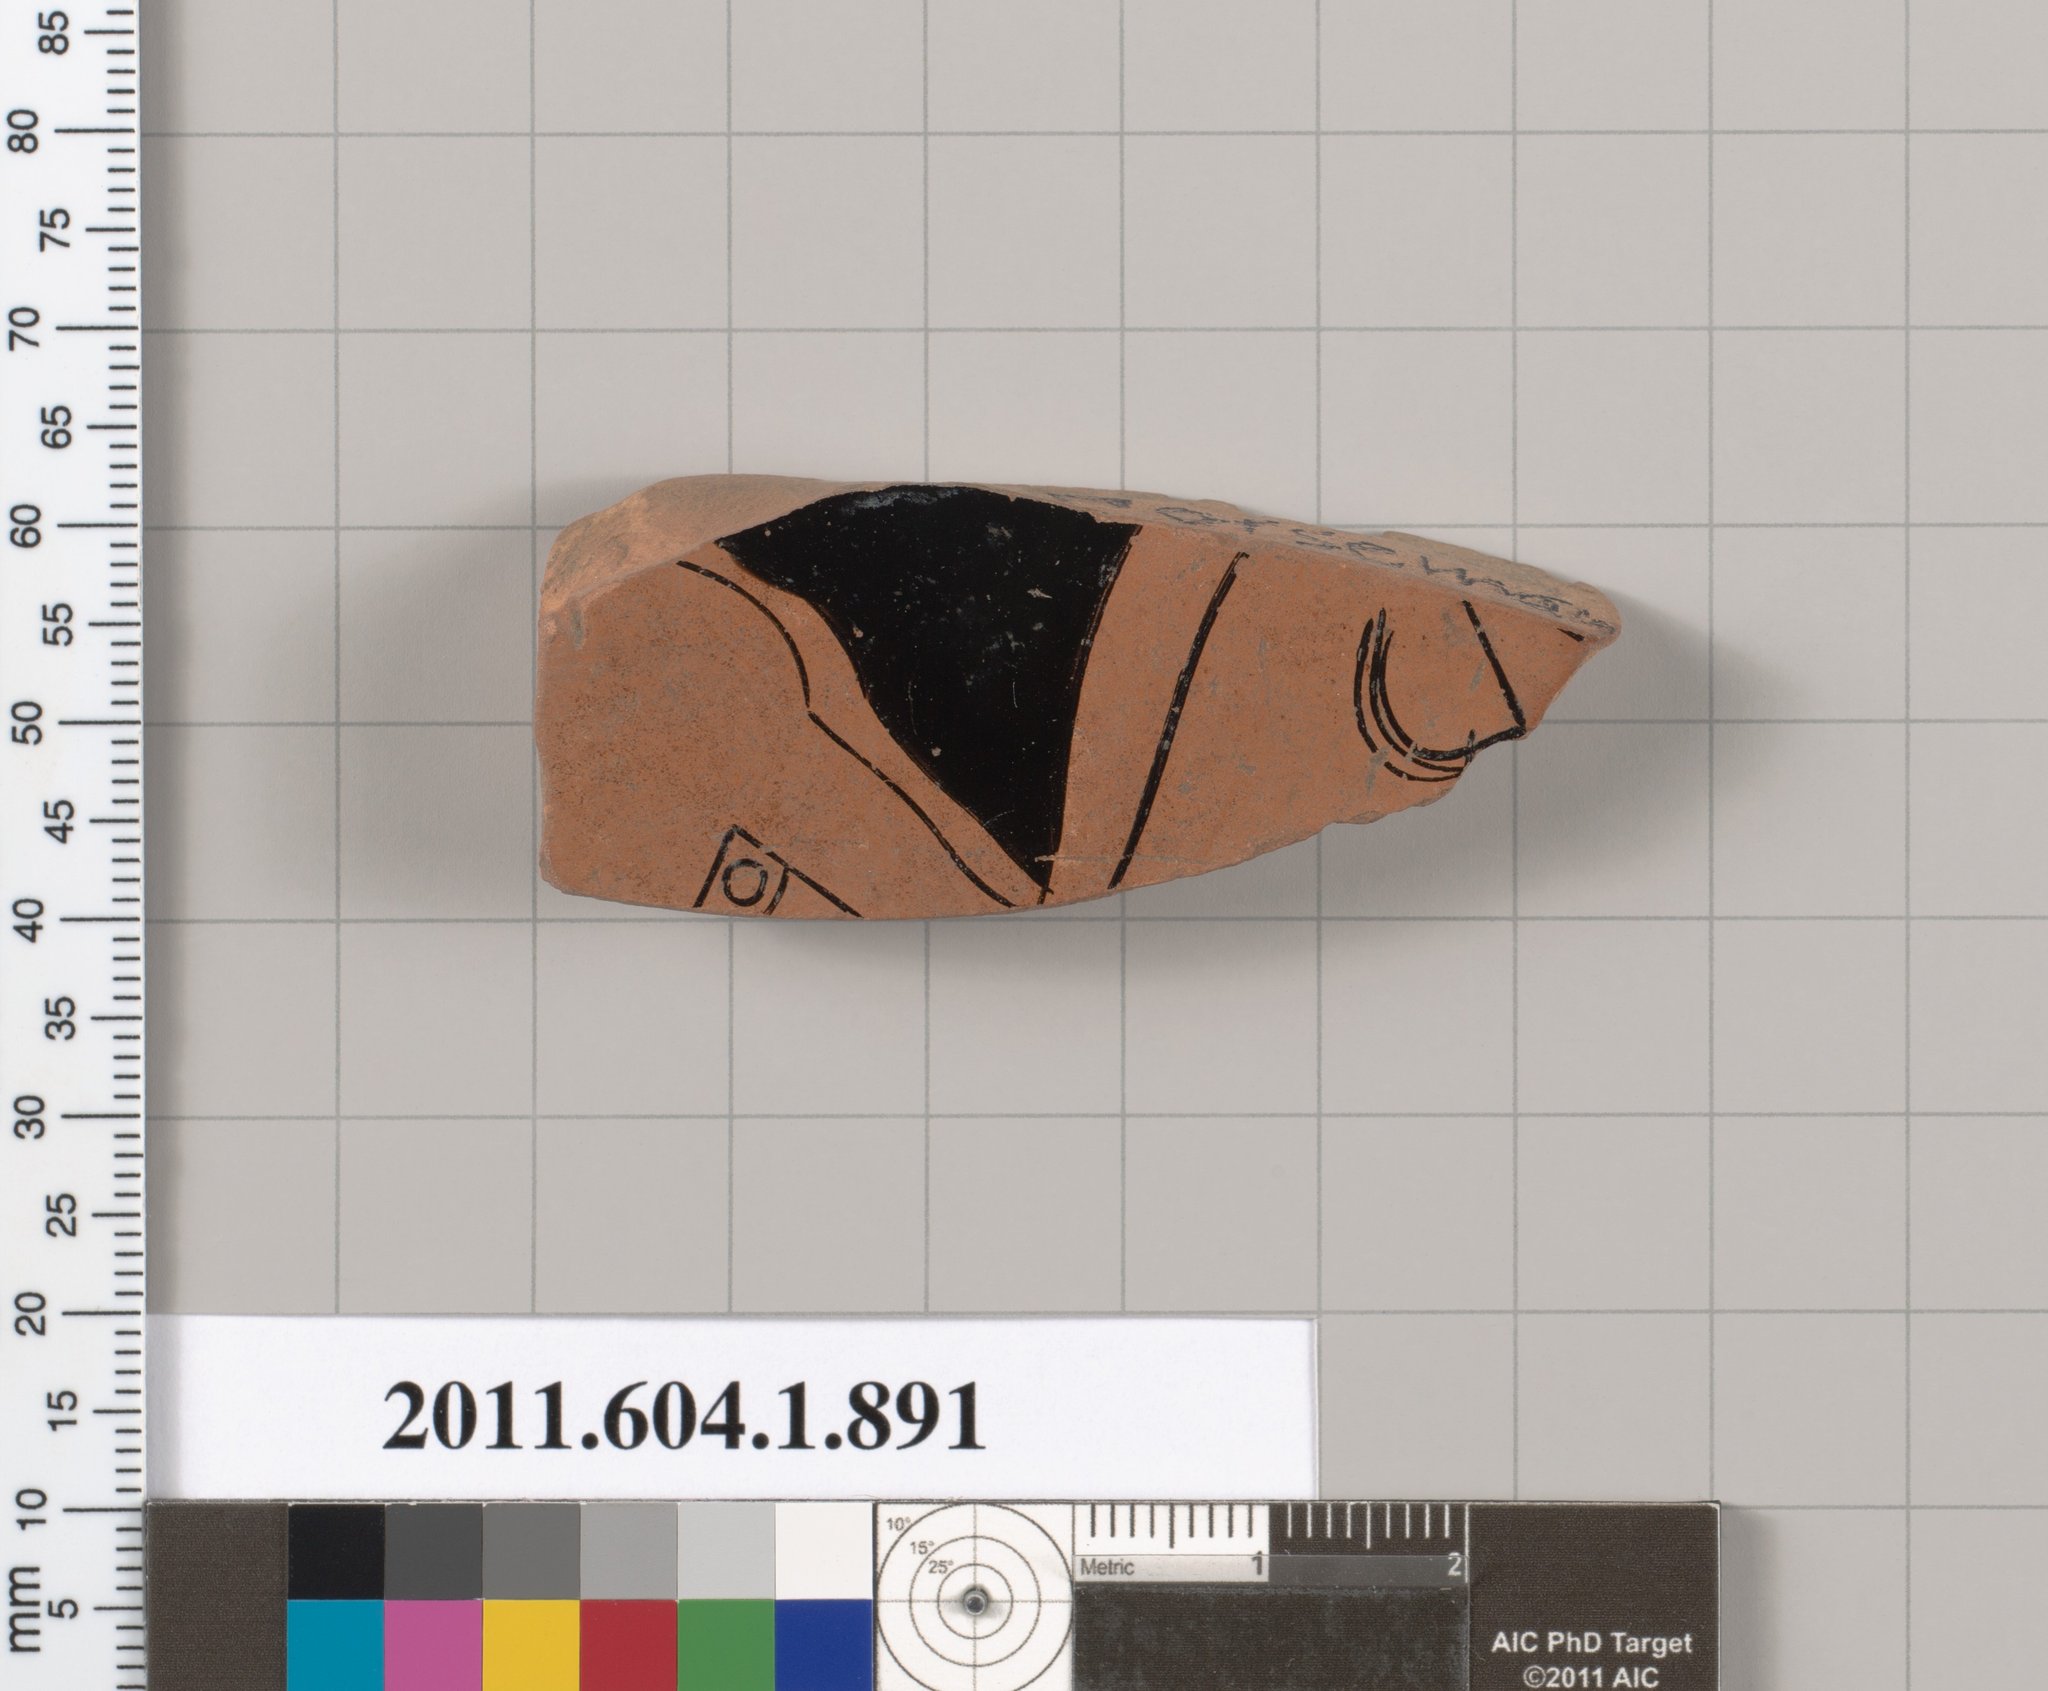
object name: kylix fragment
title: Terracotta fragment of a kylix (drinking cup)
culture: greek, attic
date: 500-476 BCE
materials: terracotta